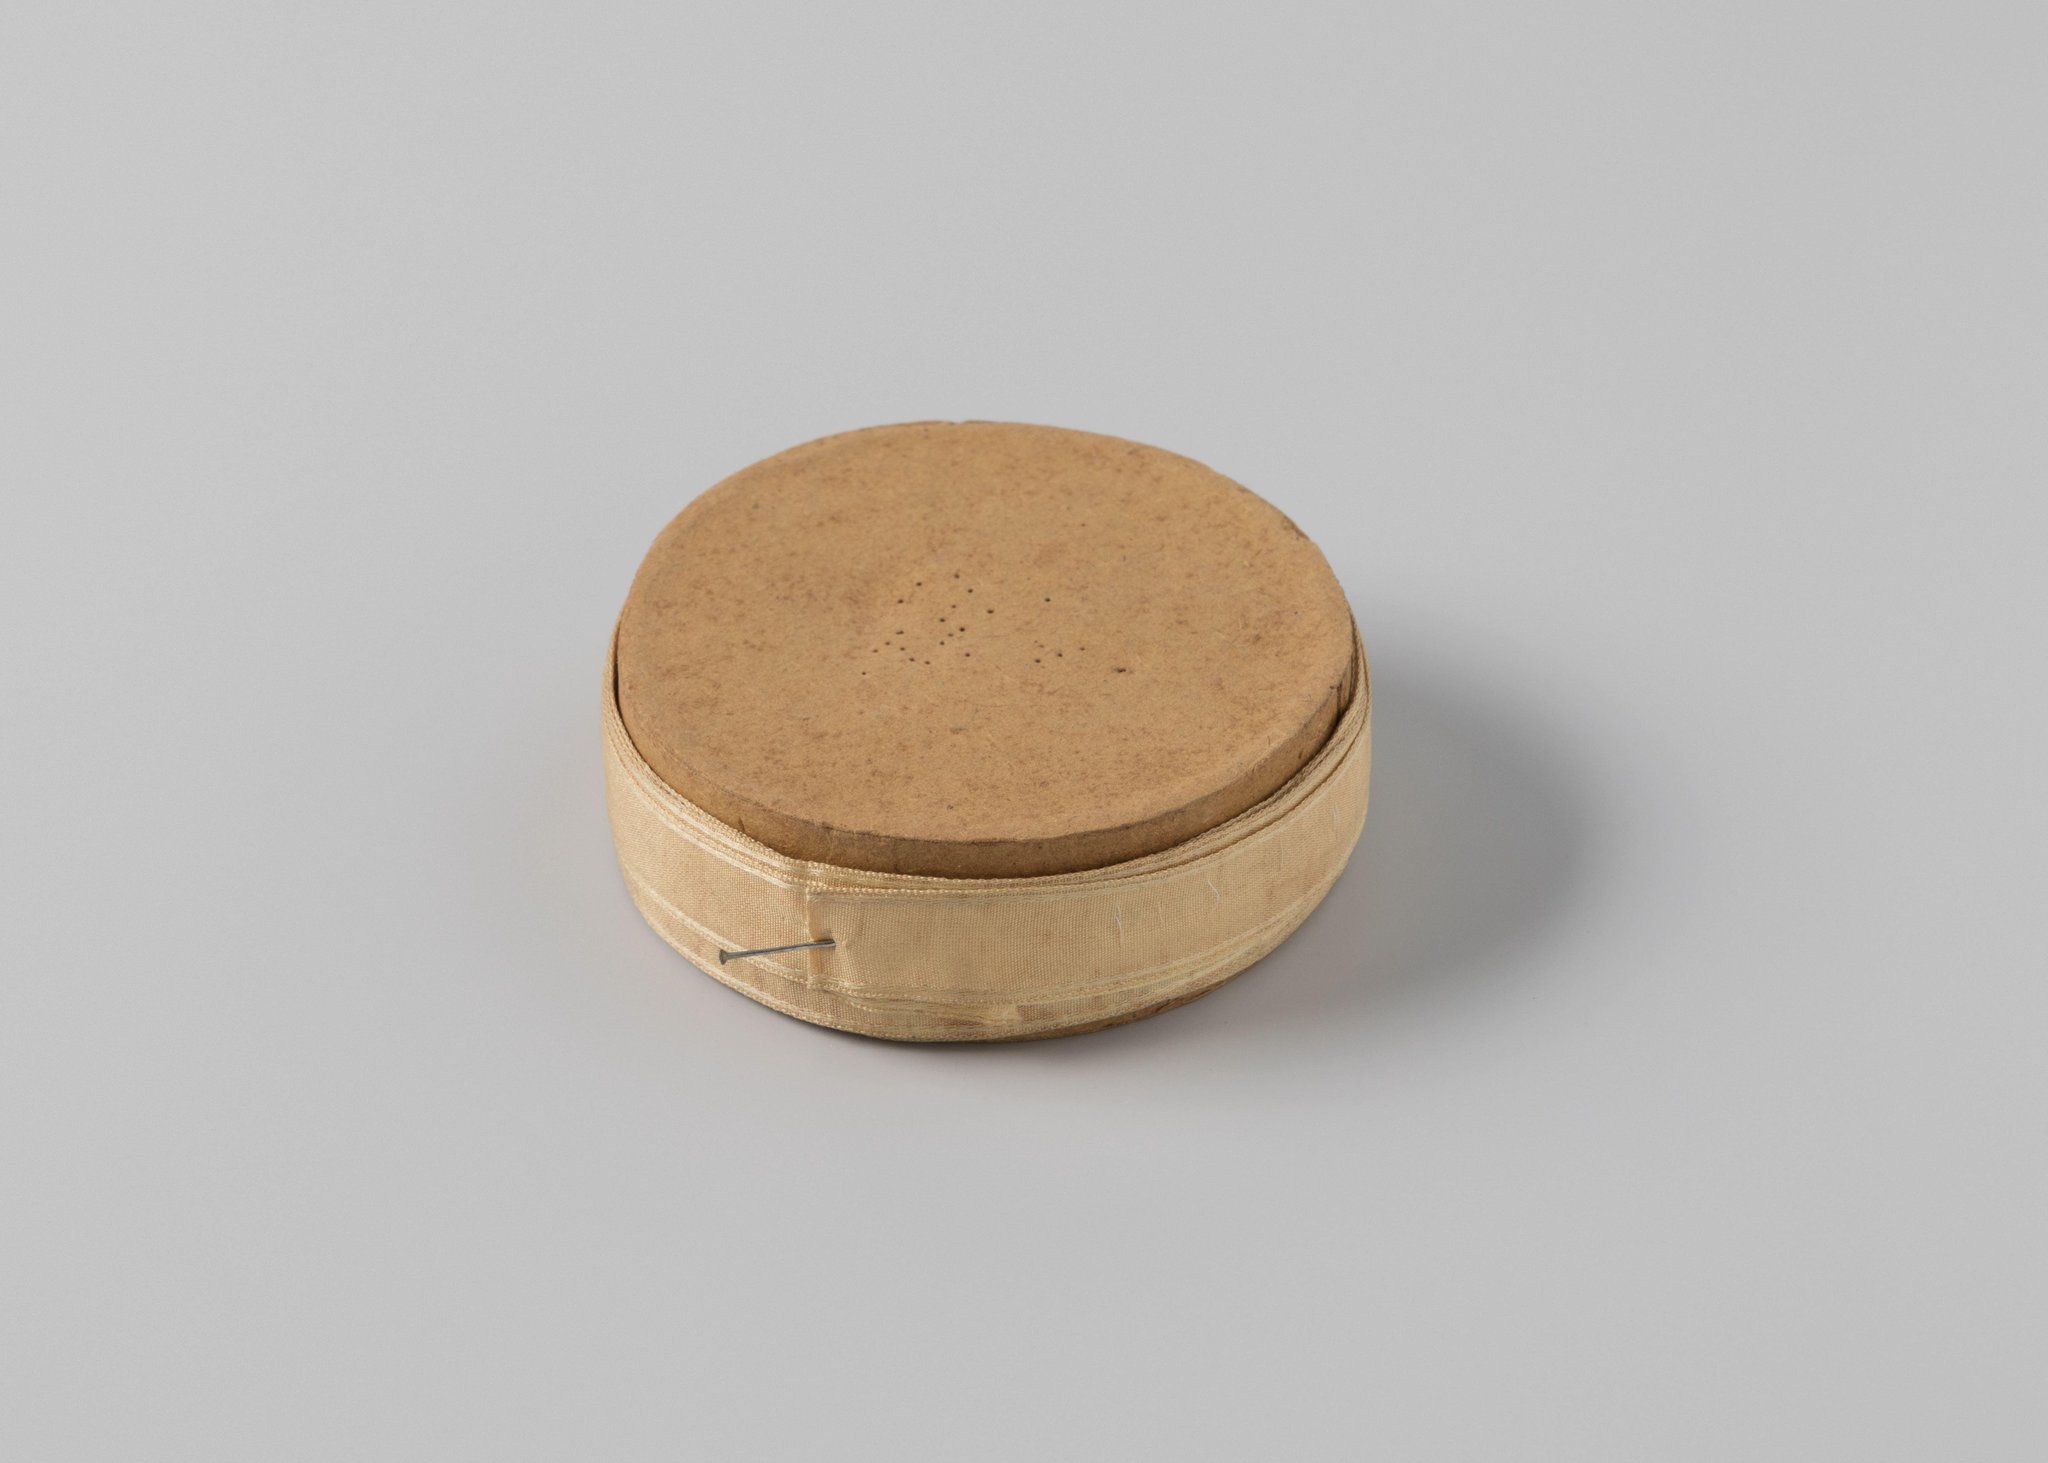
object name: braid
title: Rol met crème zijden satijnlint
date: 1925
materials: silk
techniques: satin binding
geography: nijmegen